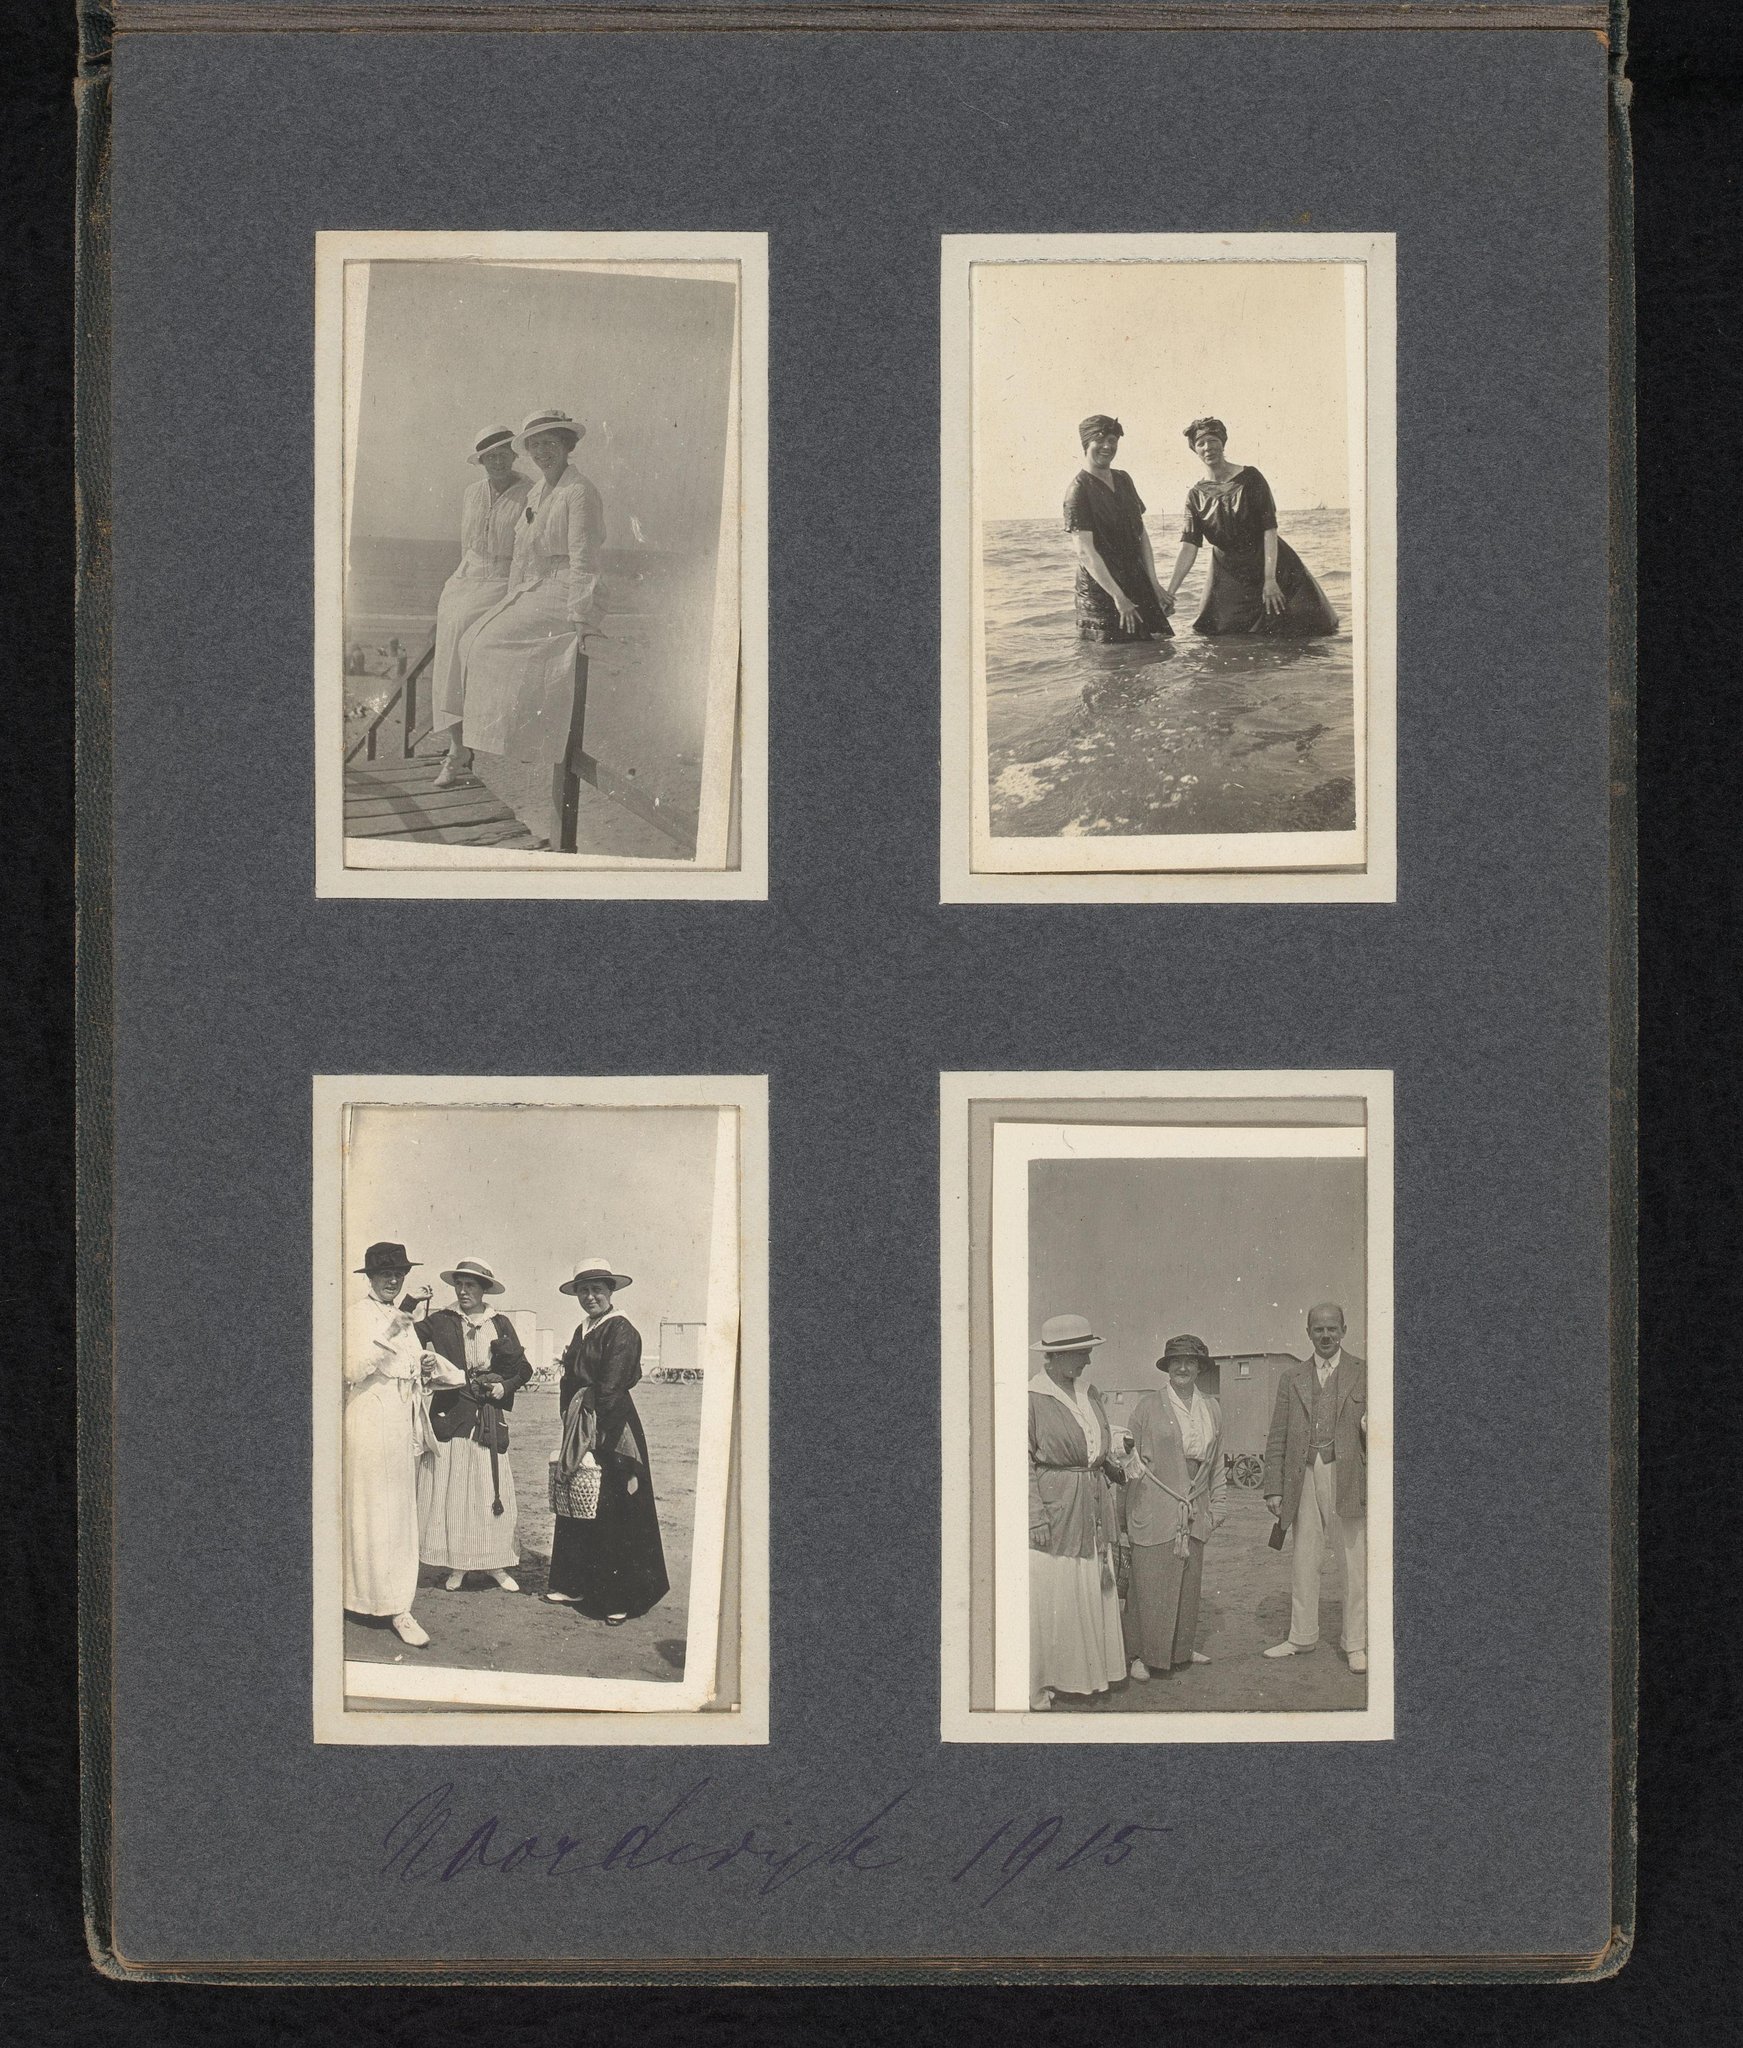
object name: album leaf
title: Familie van den Berg op het strand in Katwijk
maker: hendrik herman van den berg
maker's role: amateurfotograaf, jurist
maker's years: 1875-1944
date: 1915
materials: paper, cardboard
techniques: gelatin silver print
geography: katwijk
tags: beach (as place of recreation)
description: Deze foto's zijn onderdeel van een album.